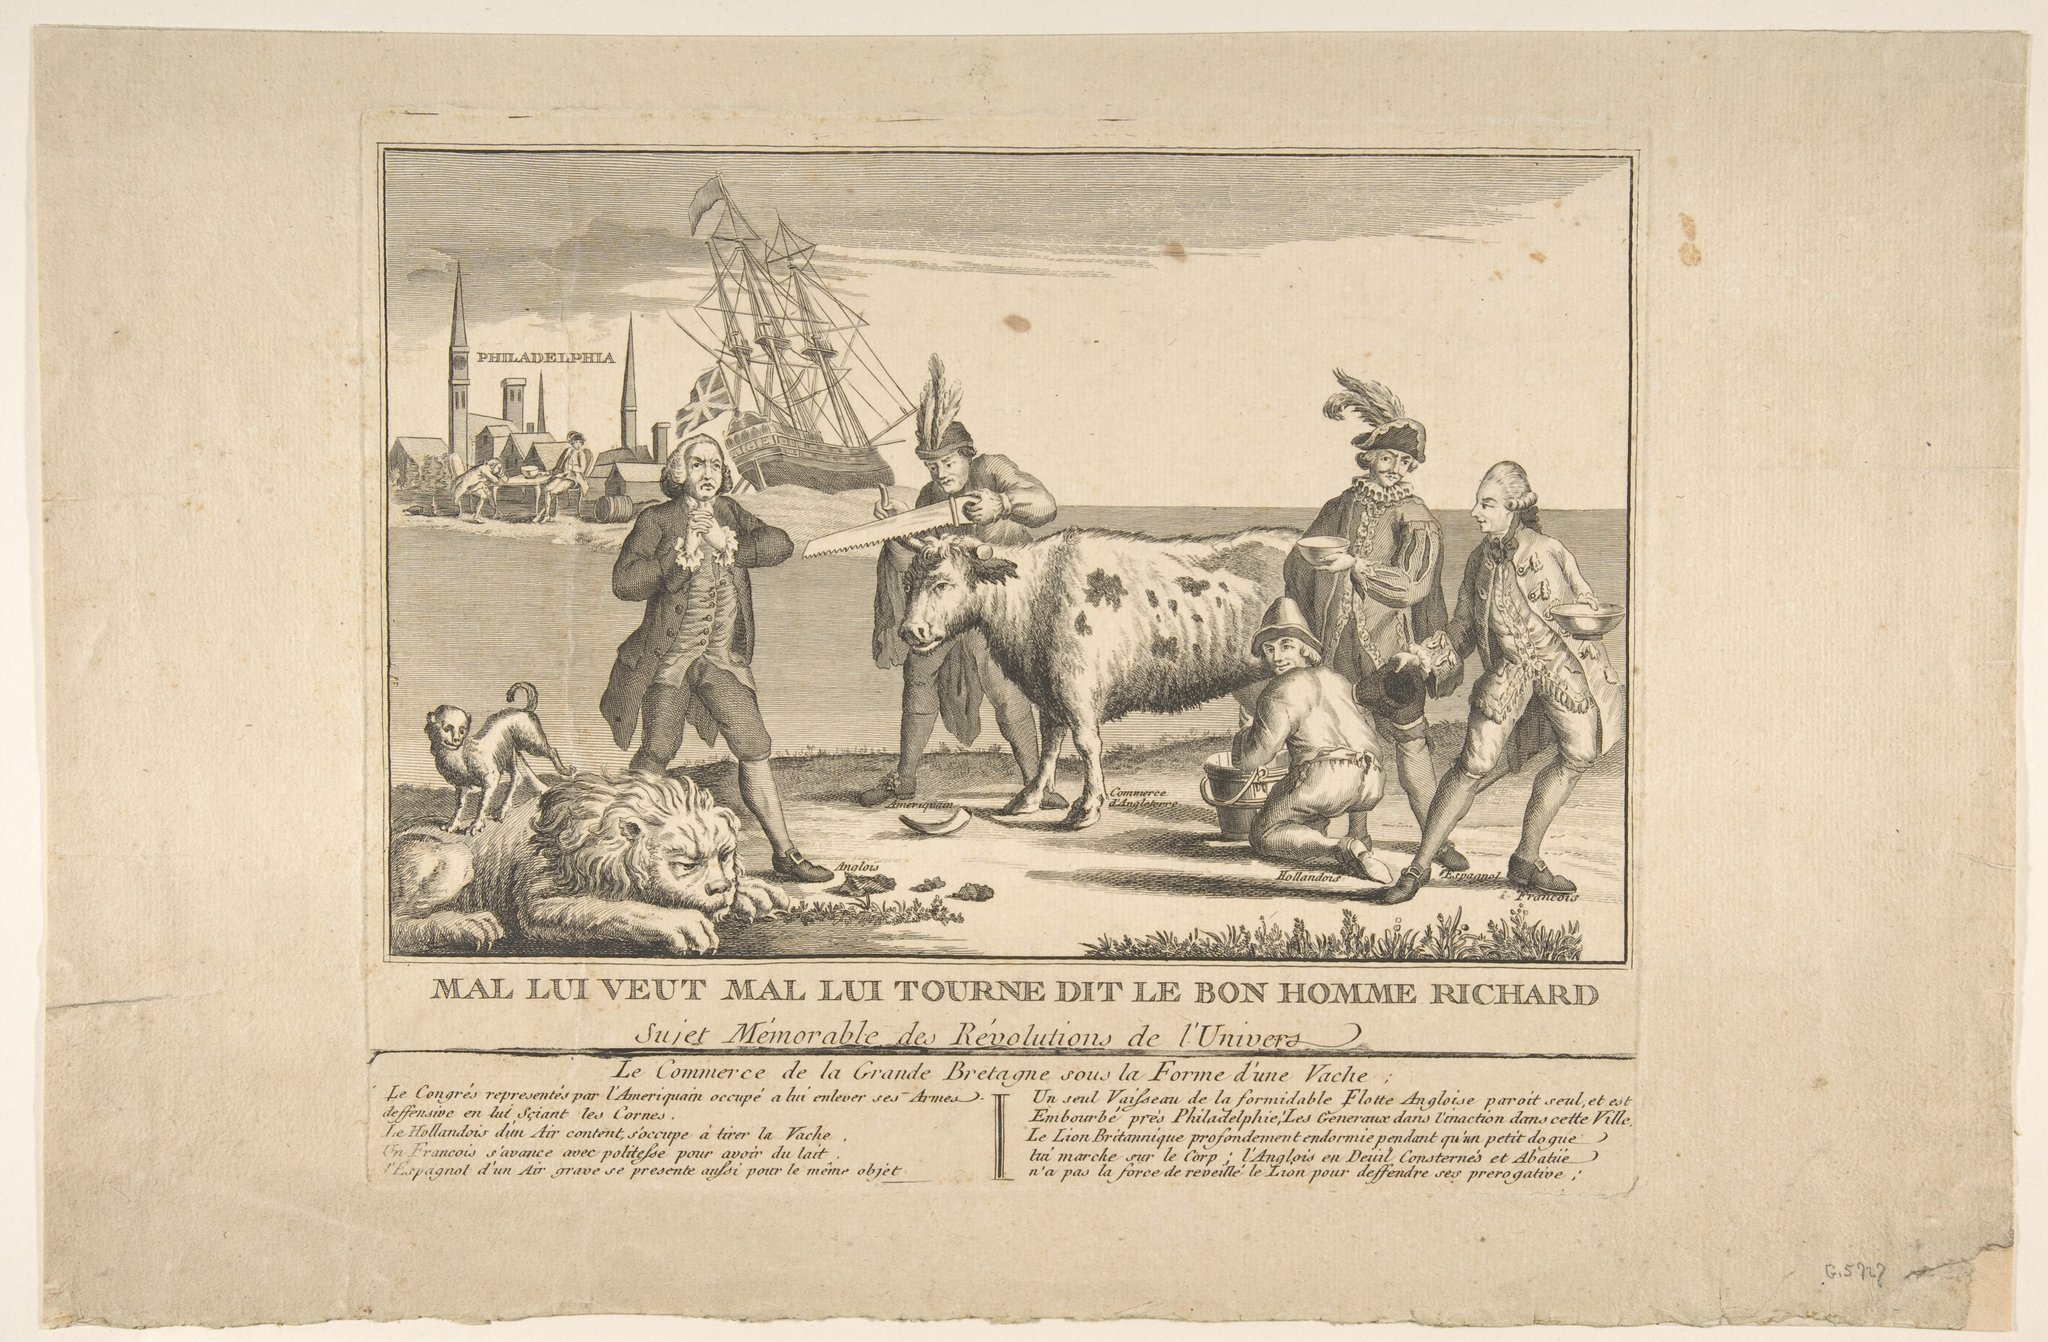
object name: print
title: Mal Lui Veut Mal Lui Tourne Dit Le Bonne Homme Richard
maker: anonymous, french, 18th century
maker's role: artist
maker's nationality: french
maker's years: 1700-1800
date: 1780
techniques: engraving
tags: satire,american revolution,men,cows,lions,ships,politics